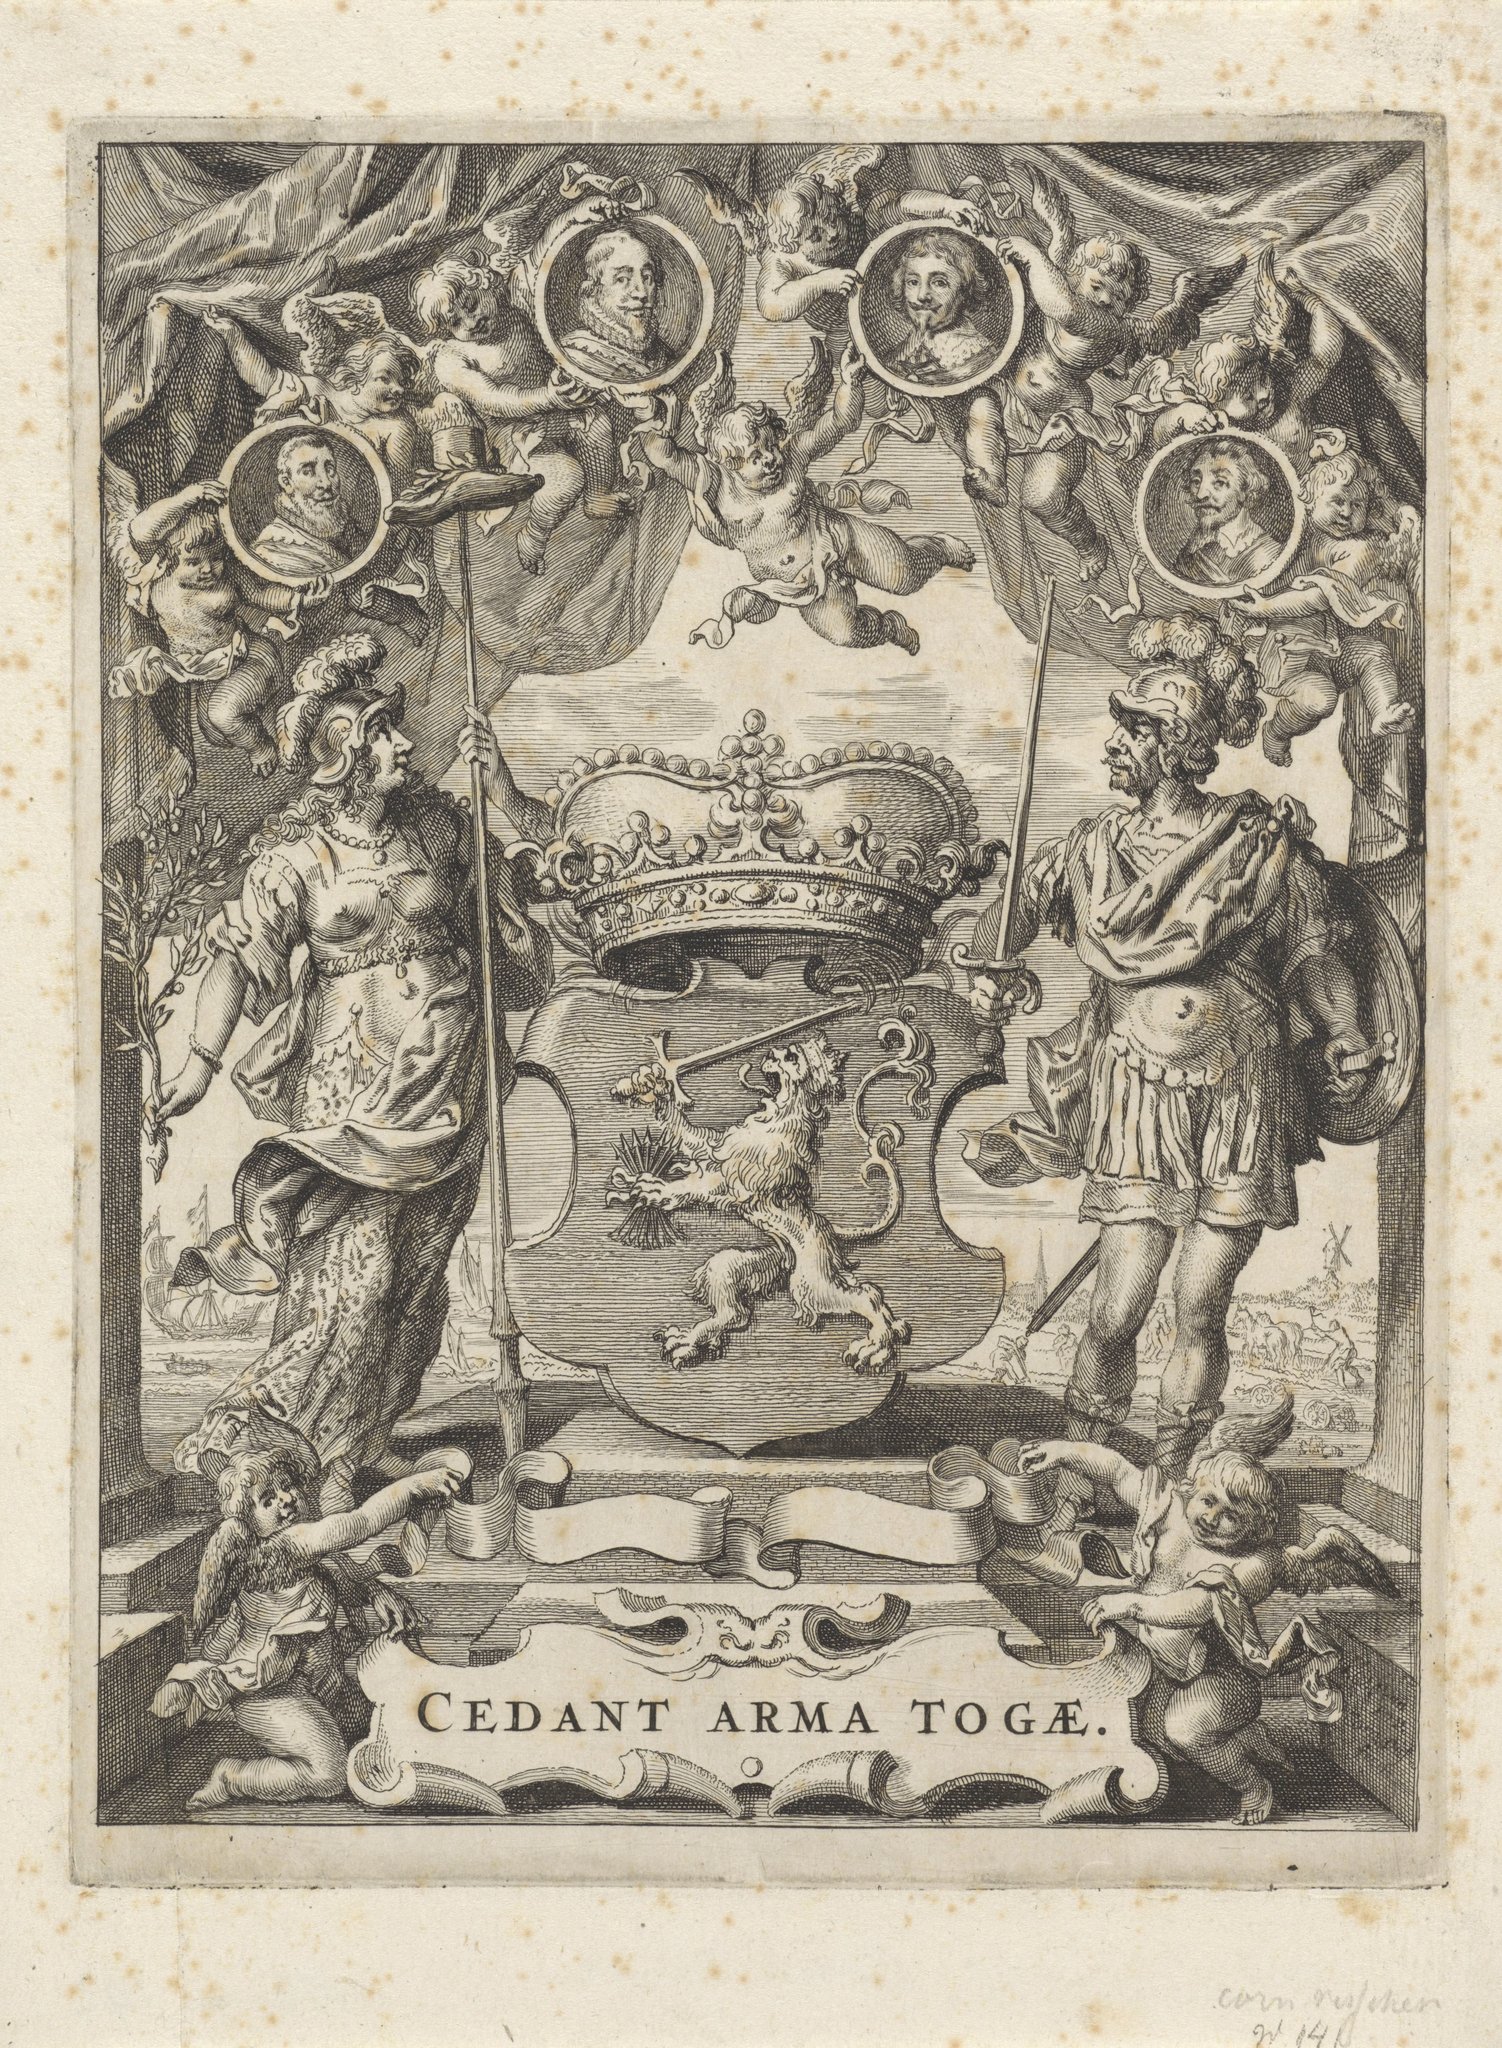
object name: titelblad, titelpagina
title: Titelpagina voor: 'Lieuwe van Aitzema, Historie of Verhael', 1657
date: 1657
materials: paper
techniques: etching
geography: haarlem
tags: crown (symbol of sovereignty), trees: olive-tree (+ plants used symbolically), cupids: 'amores', 'amoretti', 'putti'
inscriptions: collector's mark: Lugt 2228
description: Titelpagina voor 'Lieuwe van Aitzema, Historie of Verhael', met in het centrum het gekroonde wapen van Holland geflankeerd door een gewapende man en een vrouw in wapenrusting met een olijftak en de vredeshoed. Boven het wapen wordt door tal van putti vier portretten omhoog gehouden. Op de achtergrond een weidelandschap en een zeegezicht.